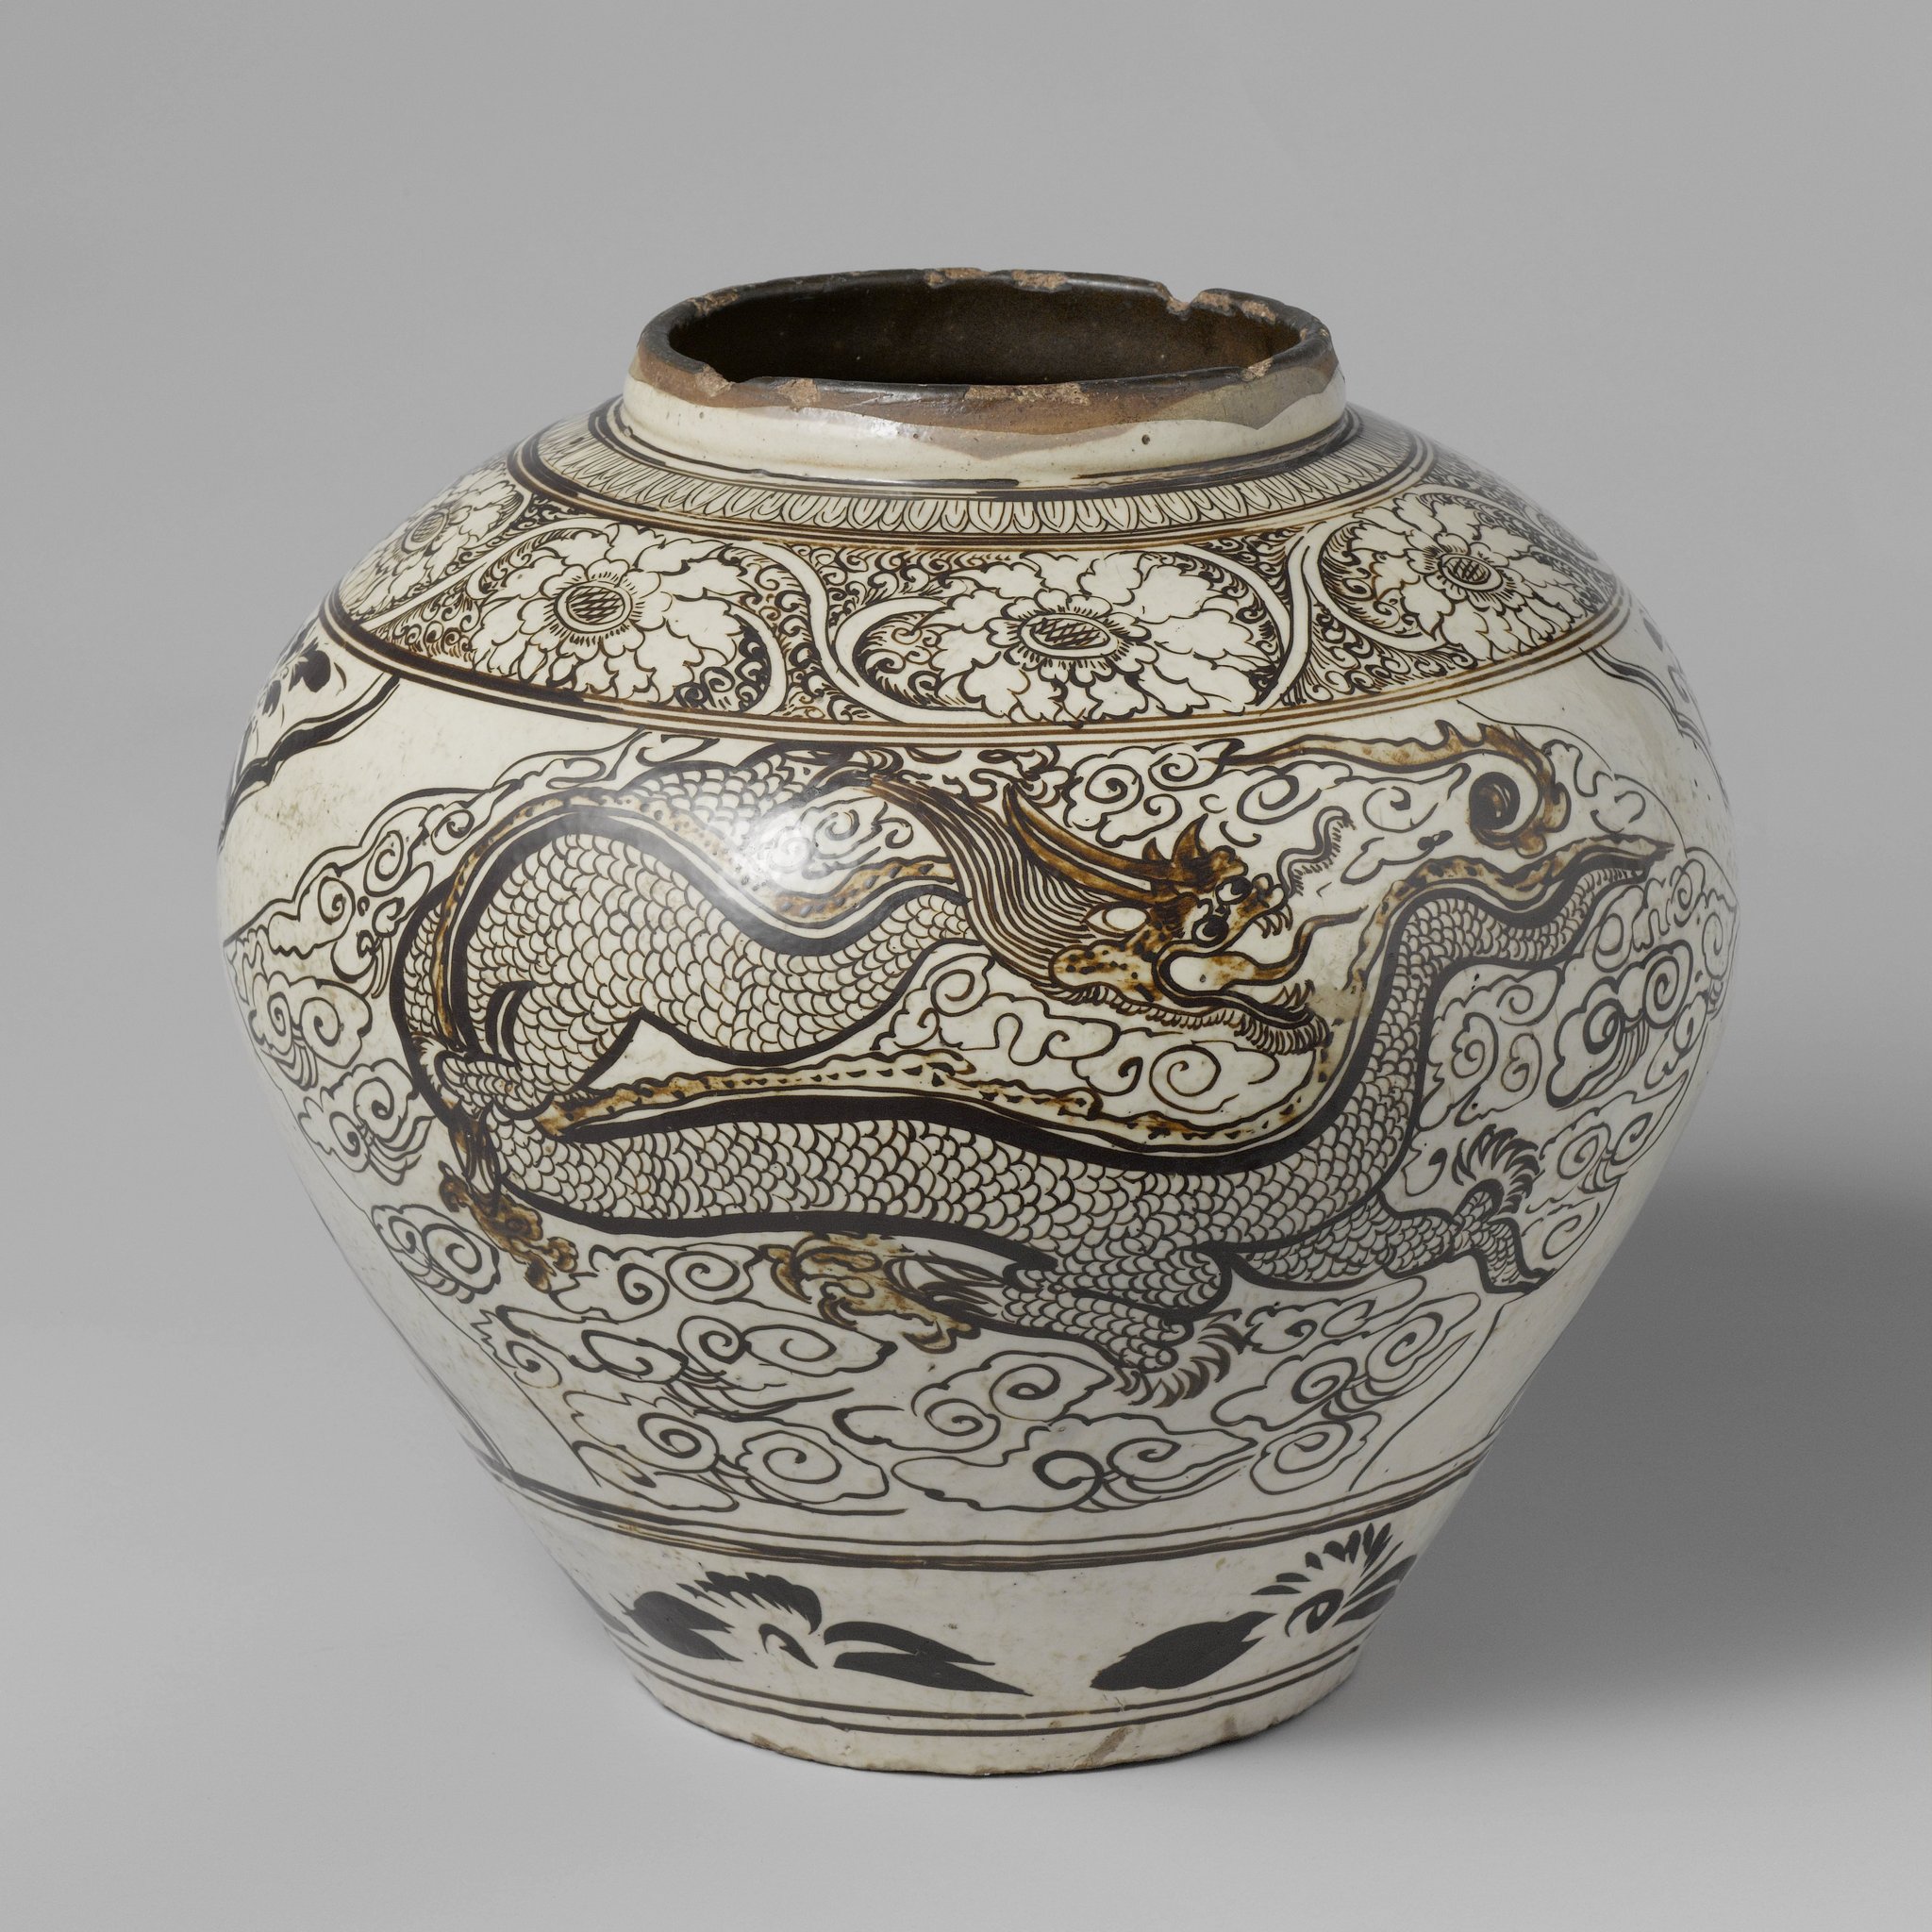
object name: pot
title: Jar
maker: Anonymous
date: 1279-1368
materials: glaze, paint, stoneware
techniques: firing, turning, vitrification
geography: china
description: This jar was executed and decorated with great skill. On one side can be seen a dragon flying among clouds, and on the other side a fenix or a fenghuang in flight. The shoulder of the jar features a band of graceful chrysanthemum scrolls and above the base is a decoration of leafy branches. The jar was used to store wine.